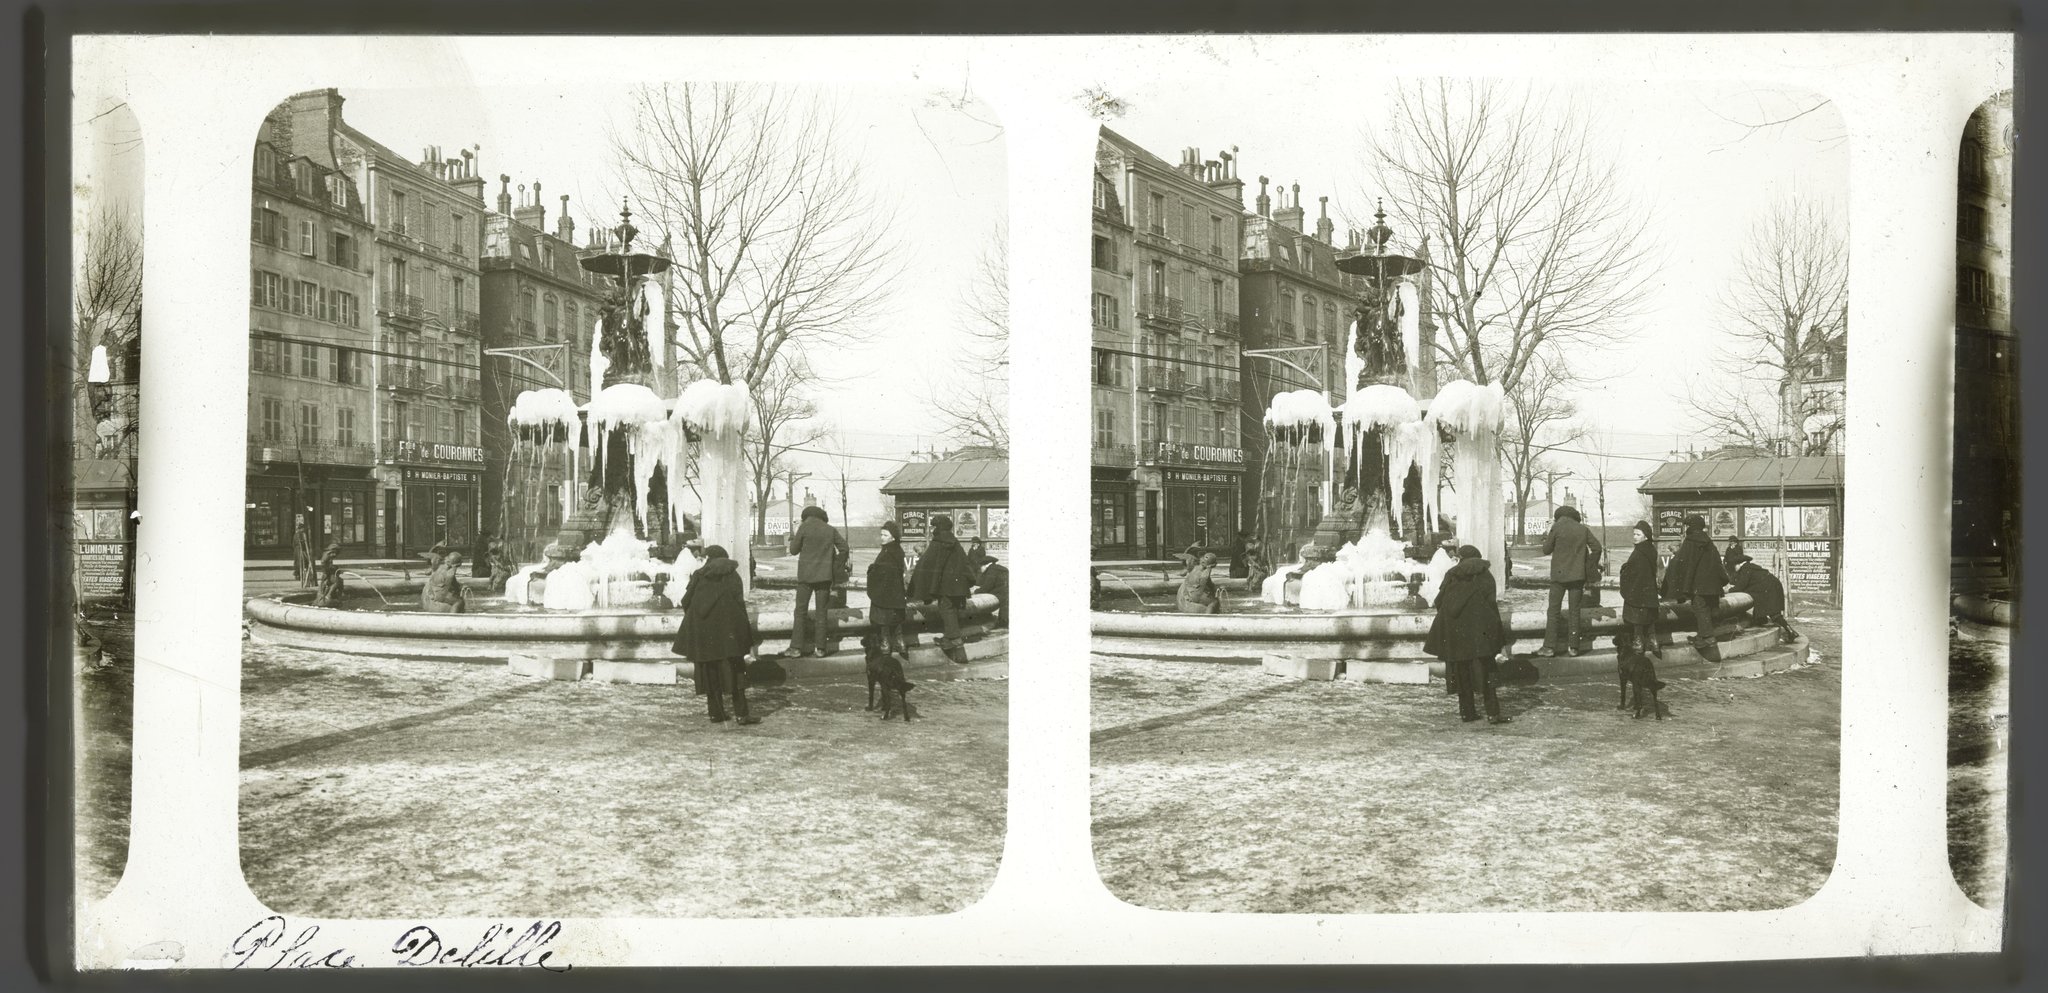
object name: stereoscopic photograph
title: Place Delille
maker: Anonymous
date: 1875-1900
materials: glass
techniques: slide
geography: clermont-ferrand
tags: ornamental fountain, ice ~ state of water